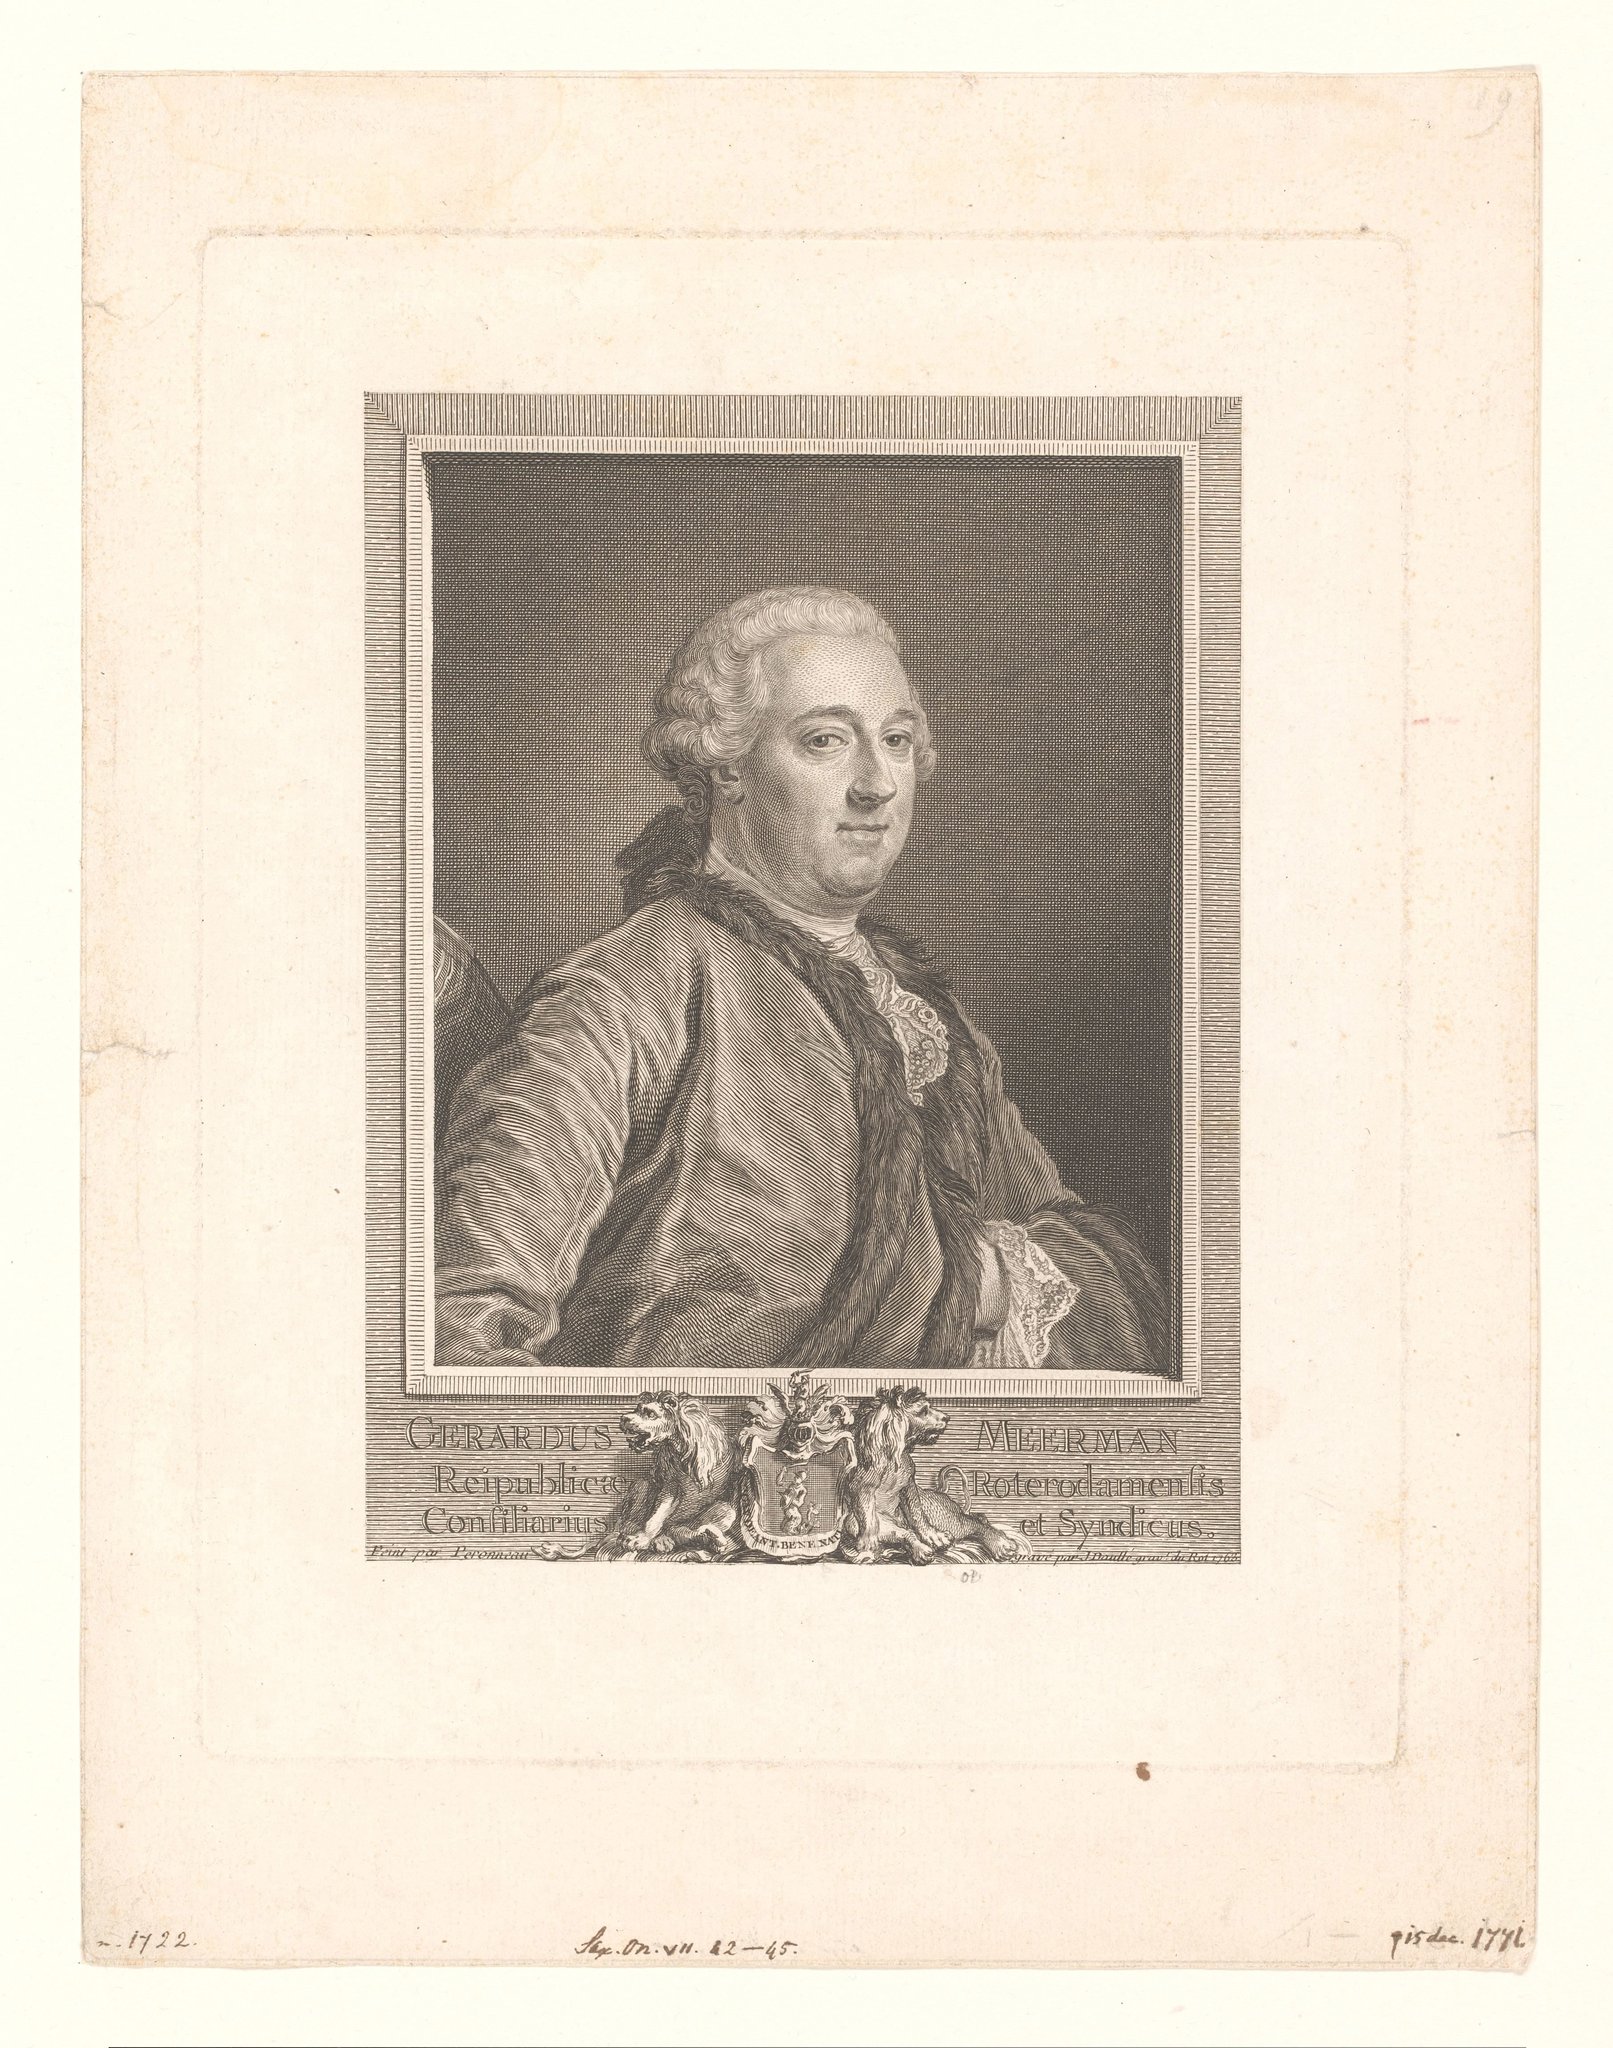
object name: print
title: Portret van Gerard Meerman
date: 1763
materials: paper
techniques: engraving, etching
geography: france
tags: historical persons, armorial bearing, heraldry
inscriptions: collector's mark: Lugt 2228, inscription: ‘1722 sax. On. VII. 42-45. 15 dec. 1771.’